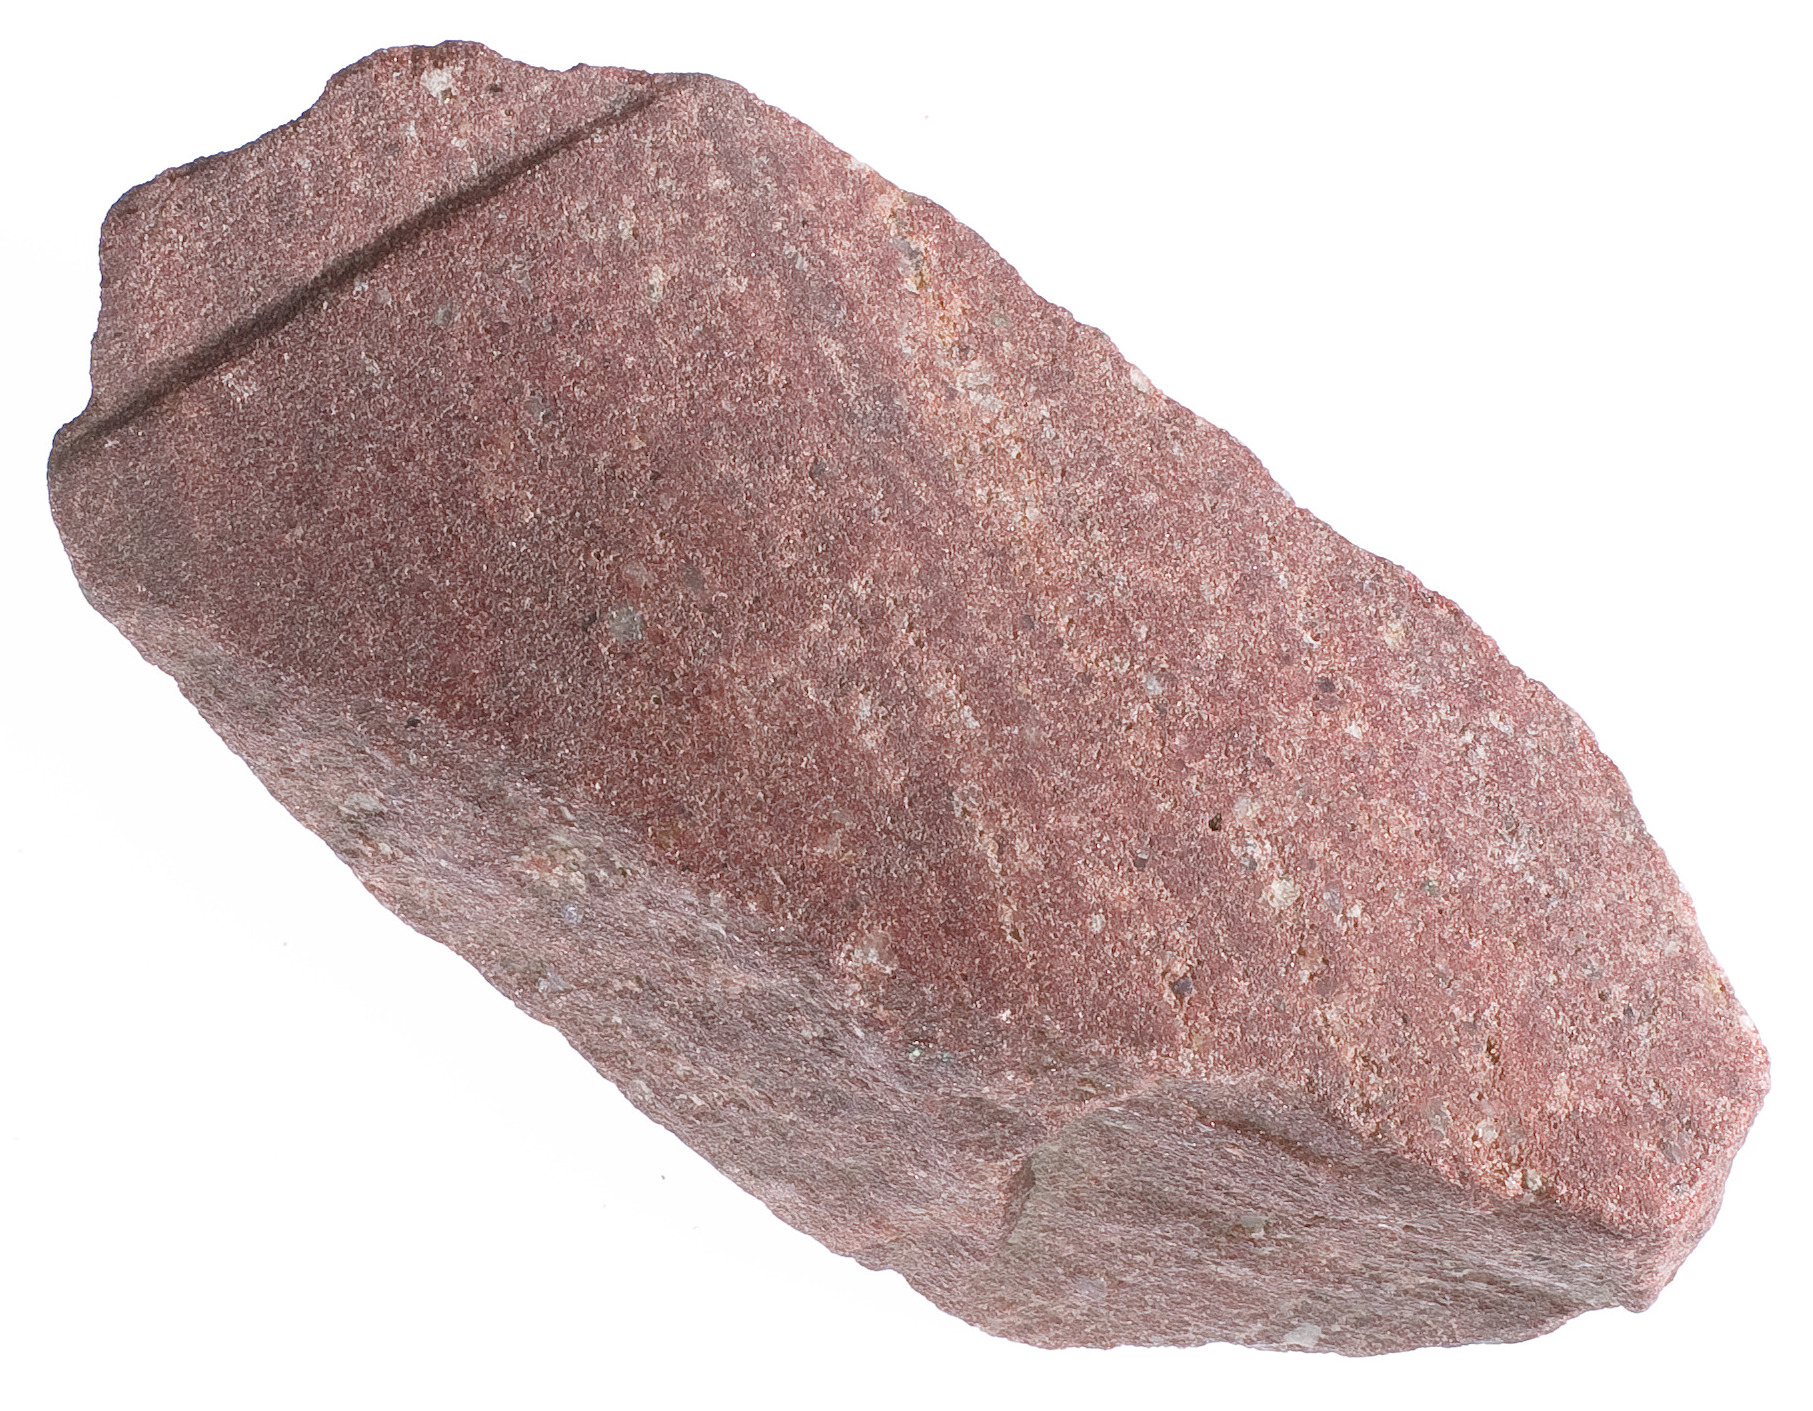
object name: flesh, garment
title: Flesh (?) and garment edge (?)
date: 1353-1336 BCE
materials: quartzite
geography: egypt